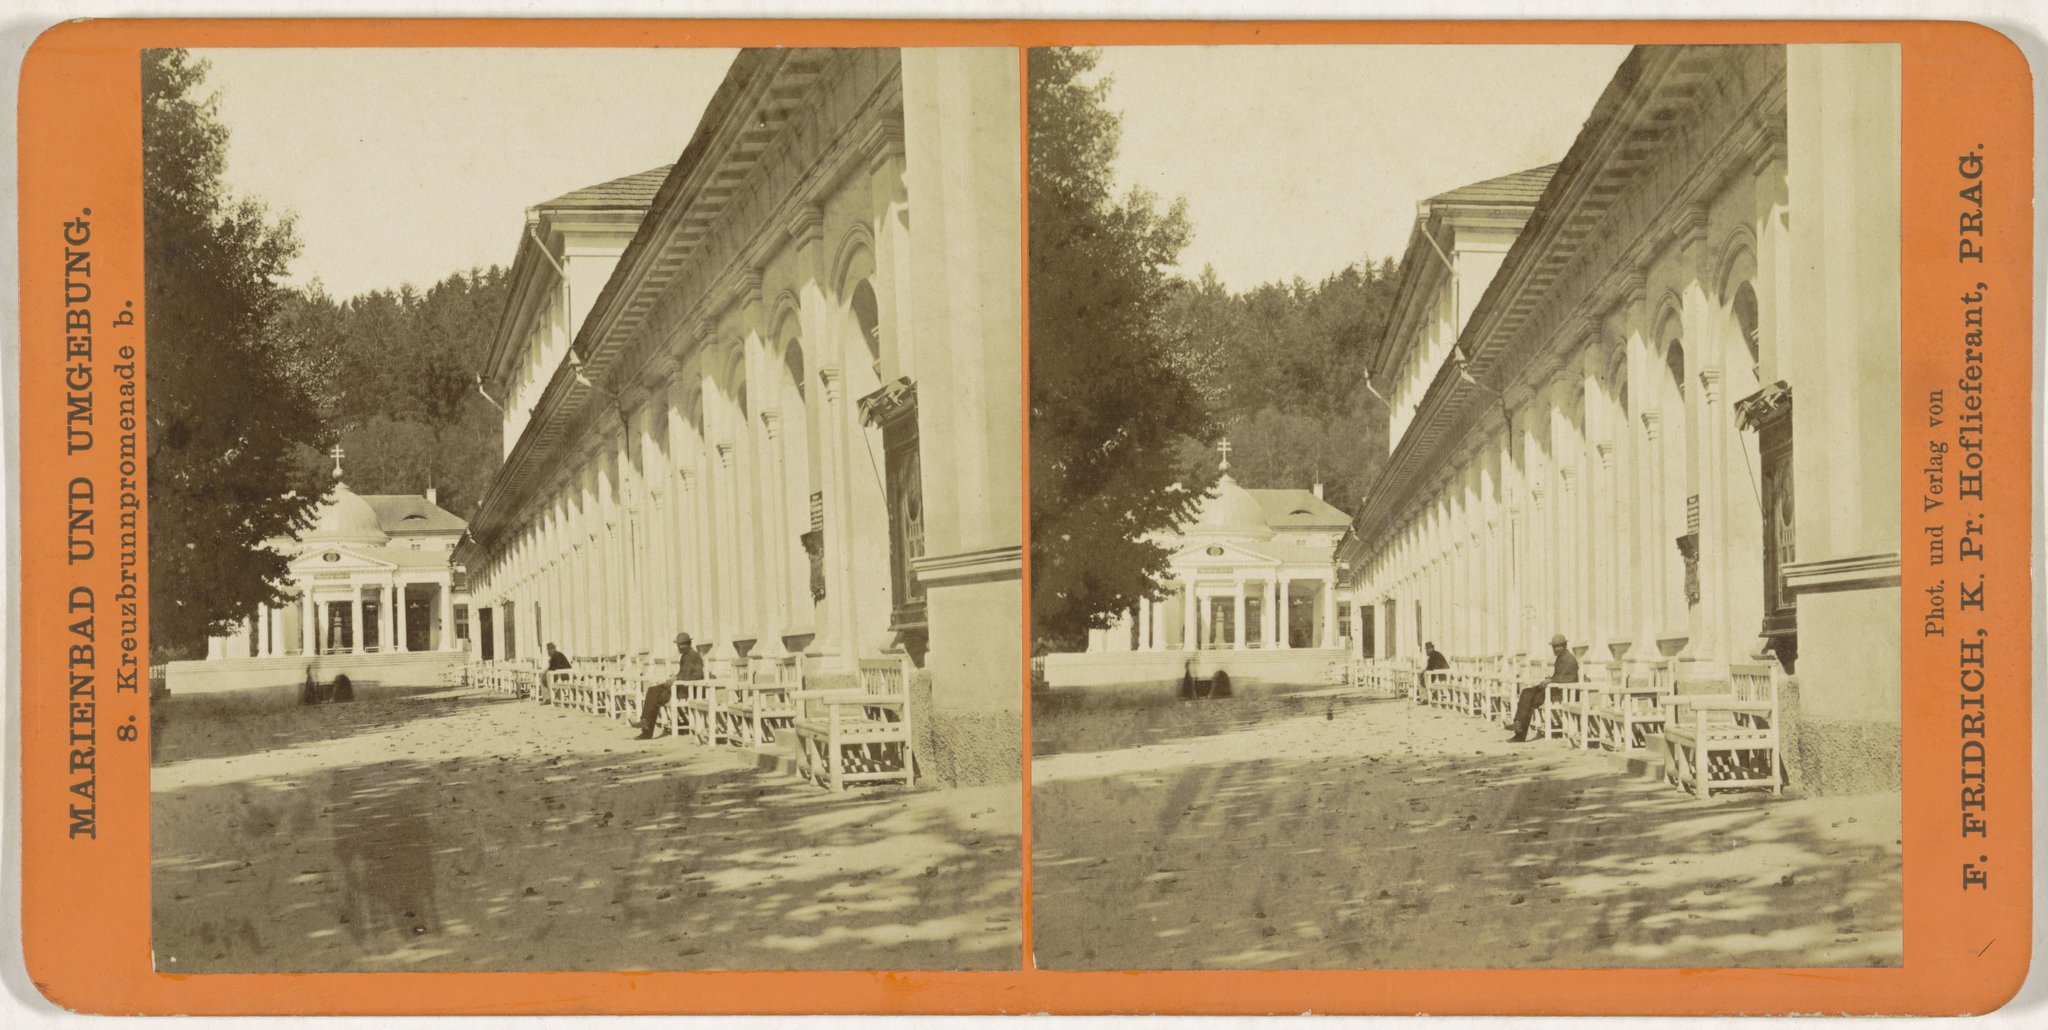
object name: stereograph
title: Kreuzbrunnpromenade b.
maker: františek fridrich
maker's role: publisher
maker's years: 1829-1892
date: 1855-1868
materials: cardboard, paper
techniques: albumen print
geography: marienbad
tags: colonnade, medicinal spring, avenue, boulevard, promenade, esplanade, marienbad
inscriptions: number: ‘8.’, inscription: ‘K. Pr. Hoflieferant’